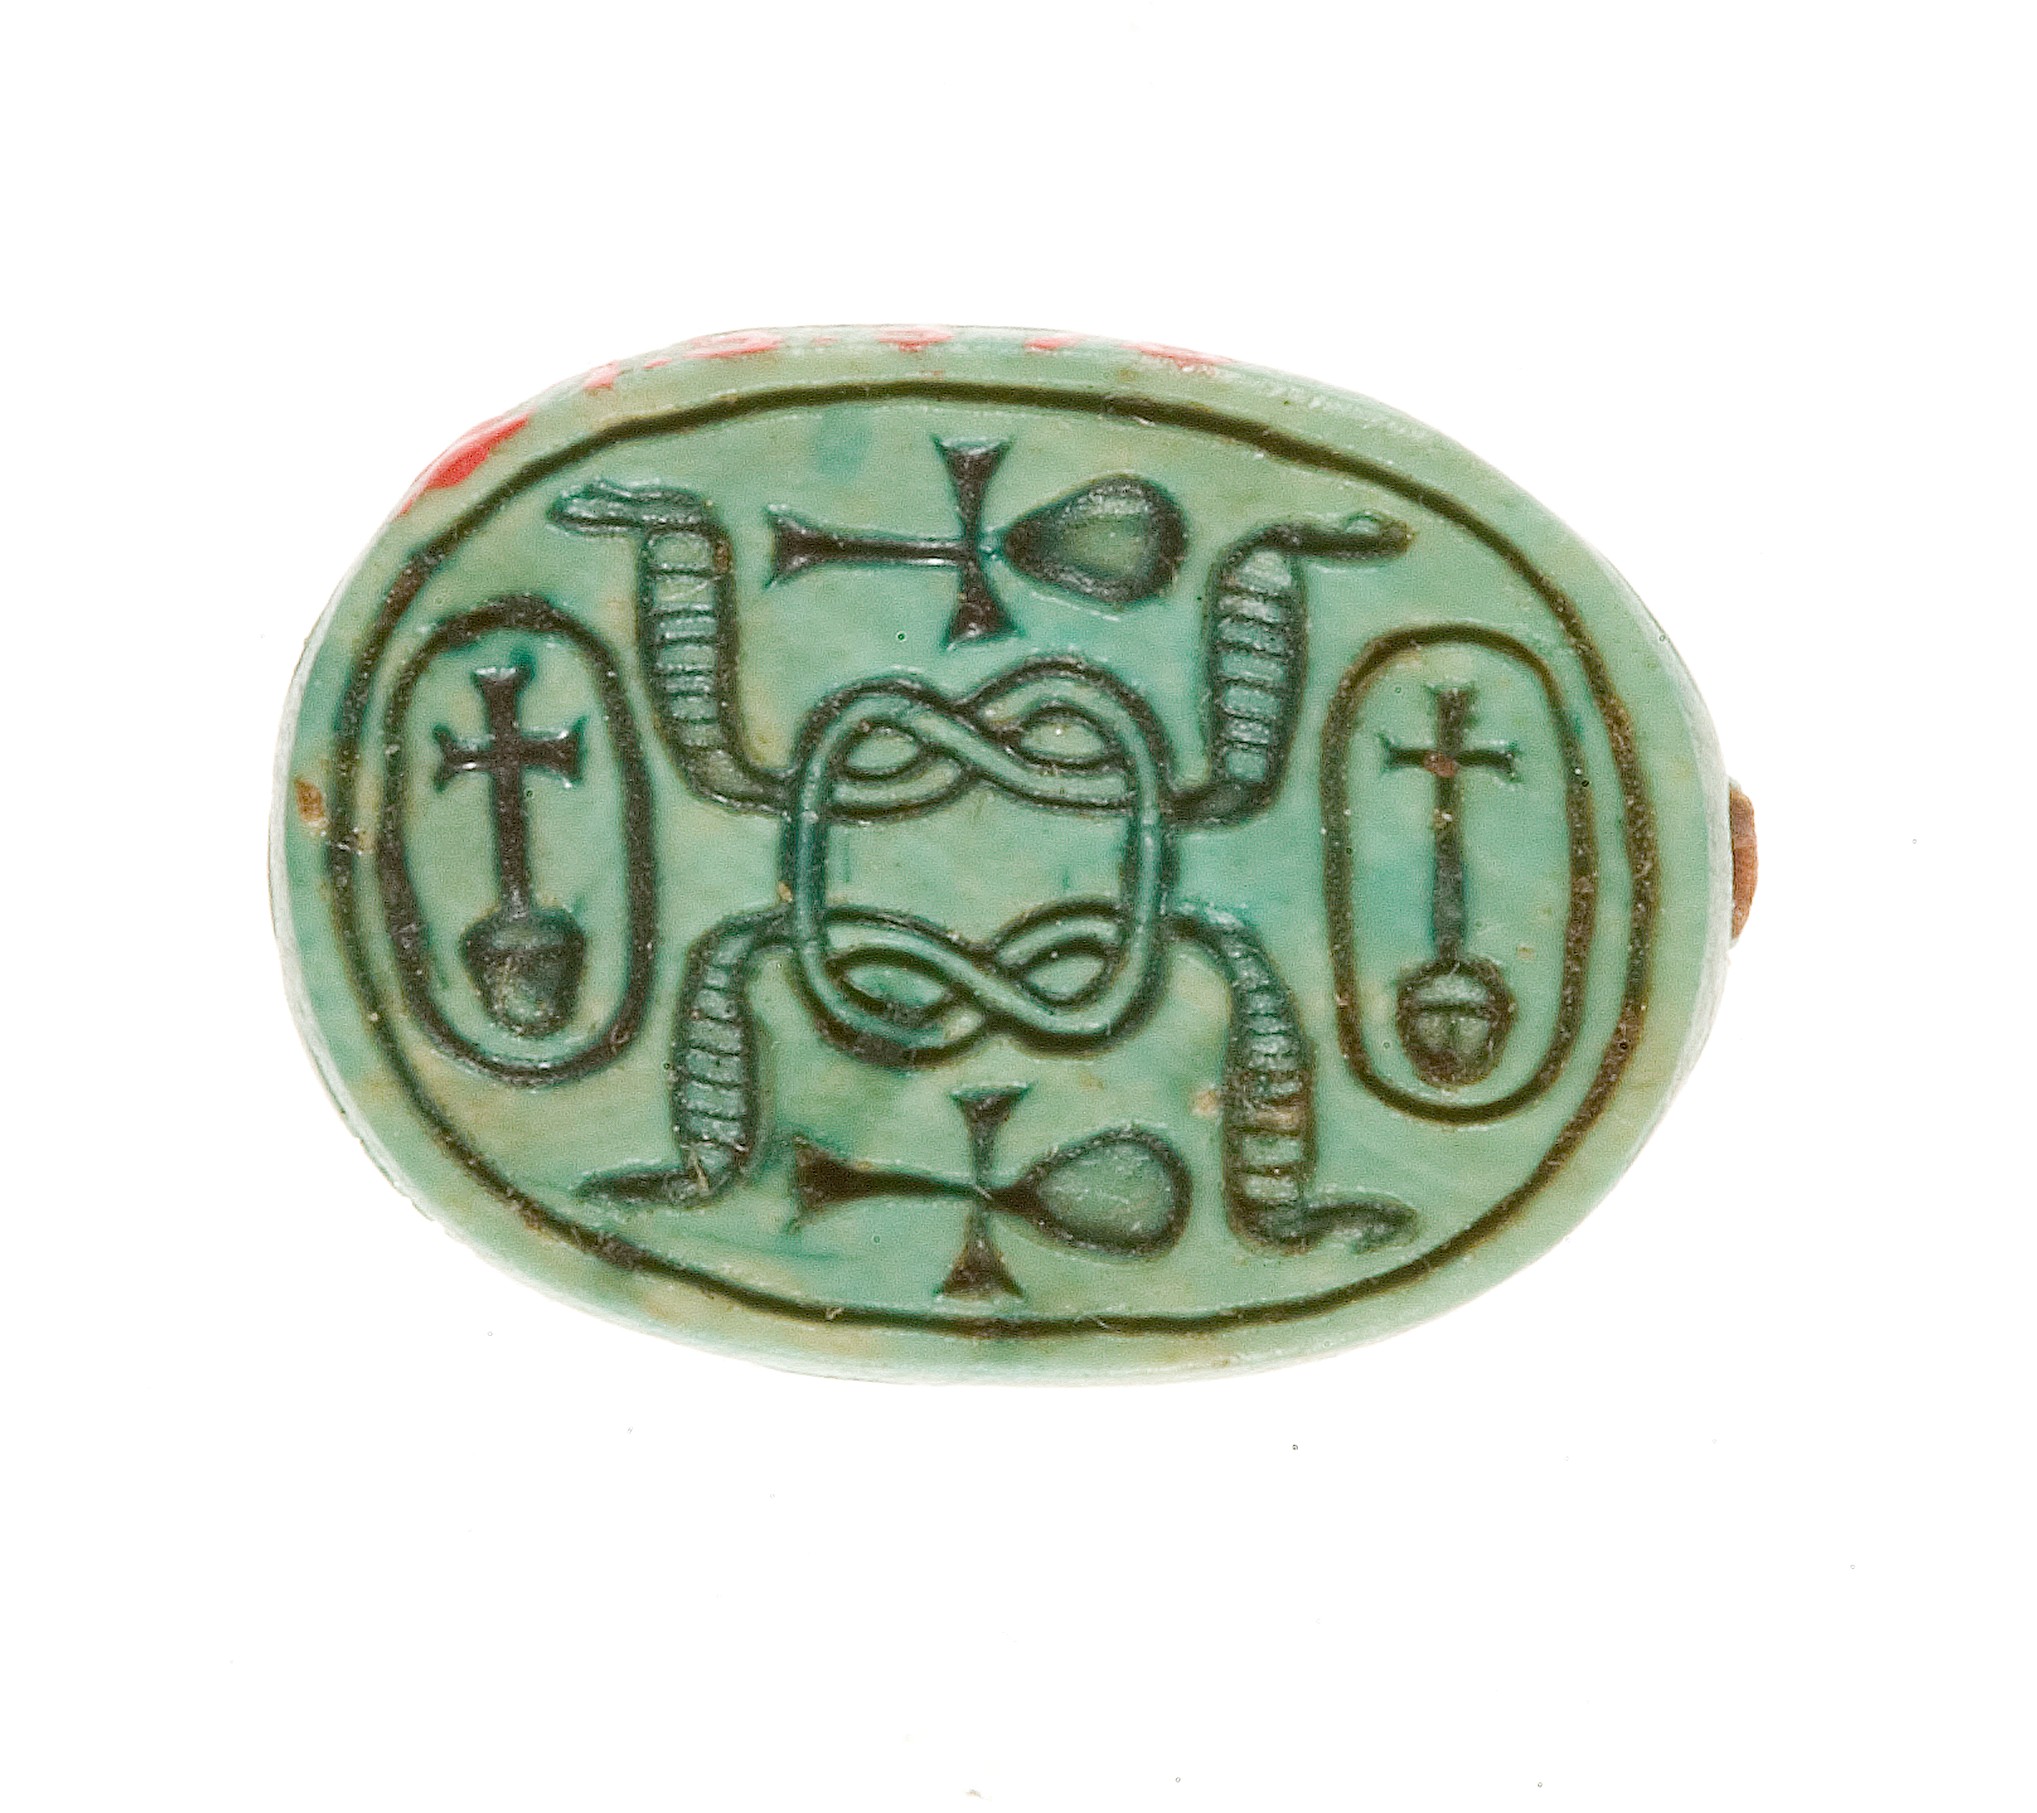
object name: scarab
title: Scarab Inscribed with a Hieroglyphic Motif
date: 1479-1458 BCE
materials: stone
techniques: glazing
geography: egypt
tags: hieroglyphs,scarabs